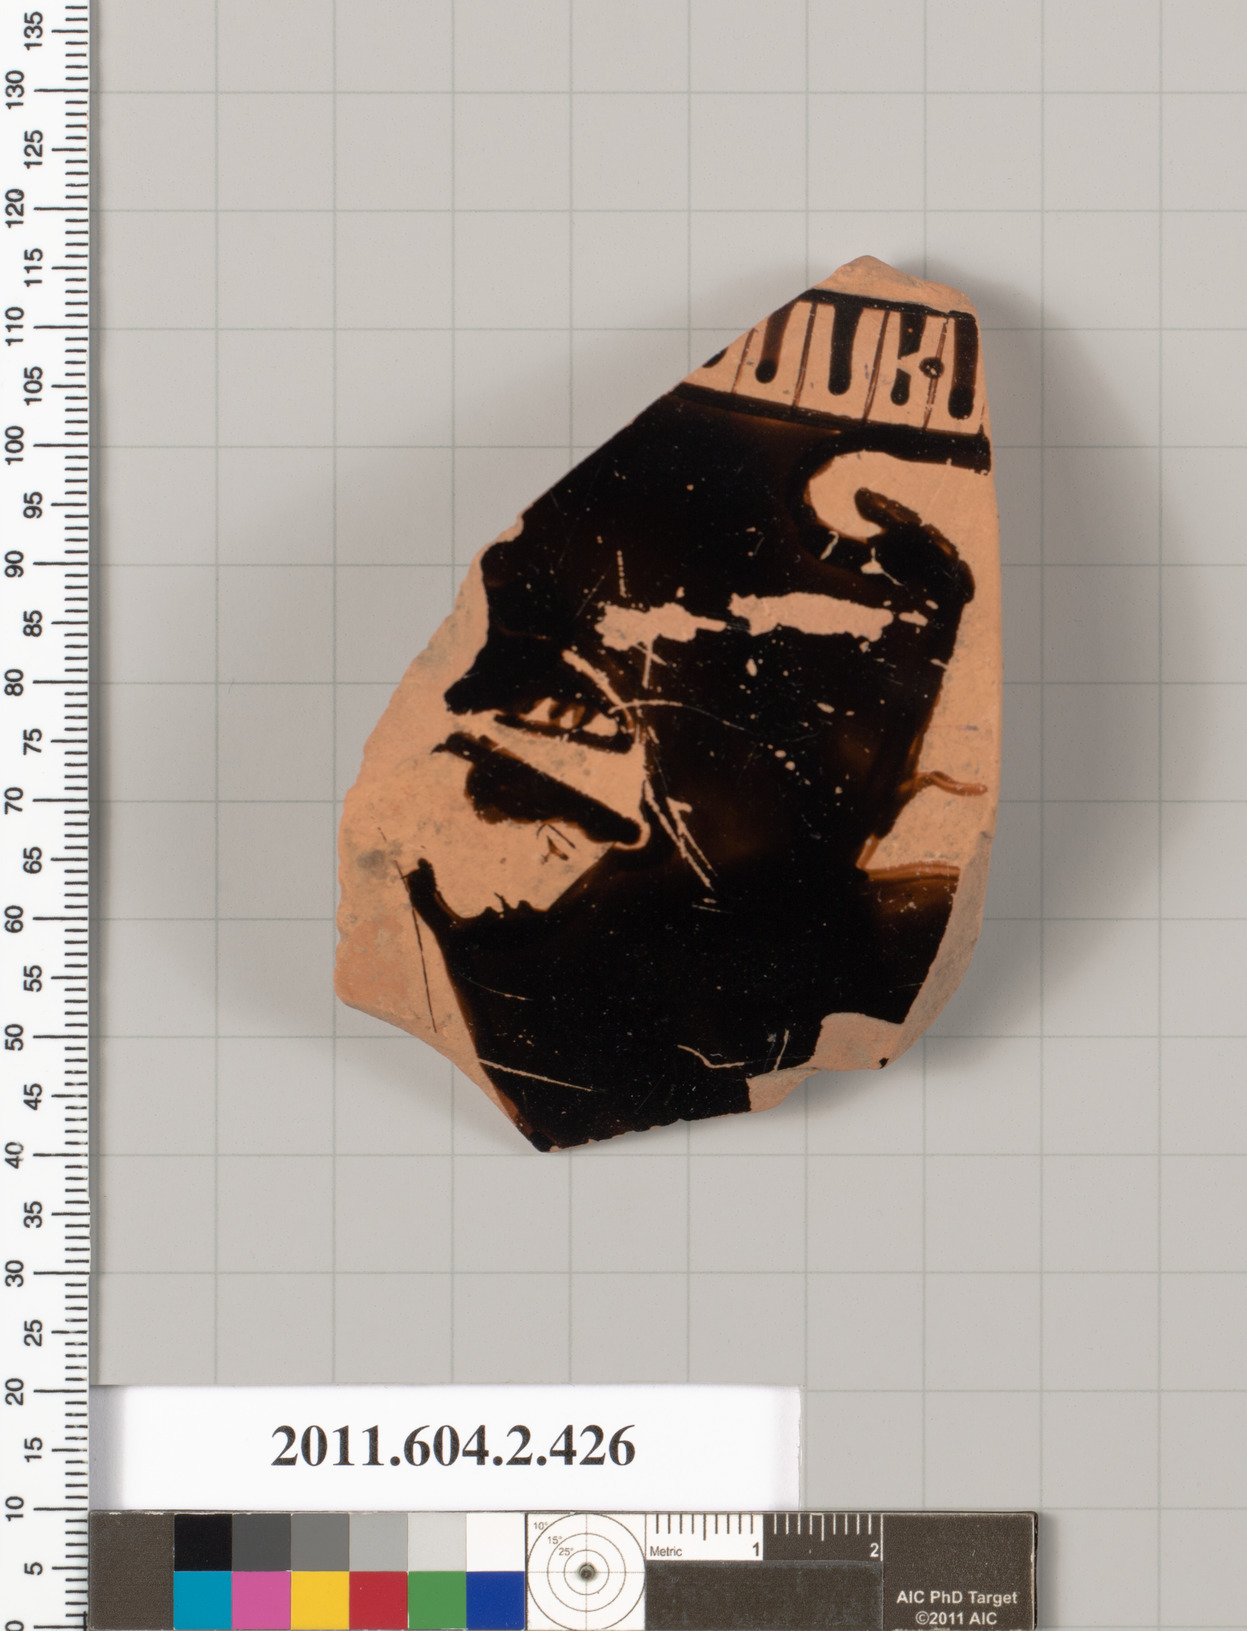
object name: column krater fragment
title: Terracotta fragment of a column-krater (bowl for mixing wine and water)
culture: greek, attic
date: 460-440 BCE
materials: terracotta